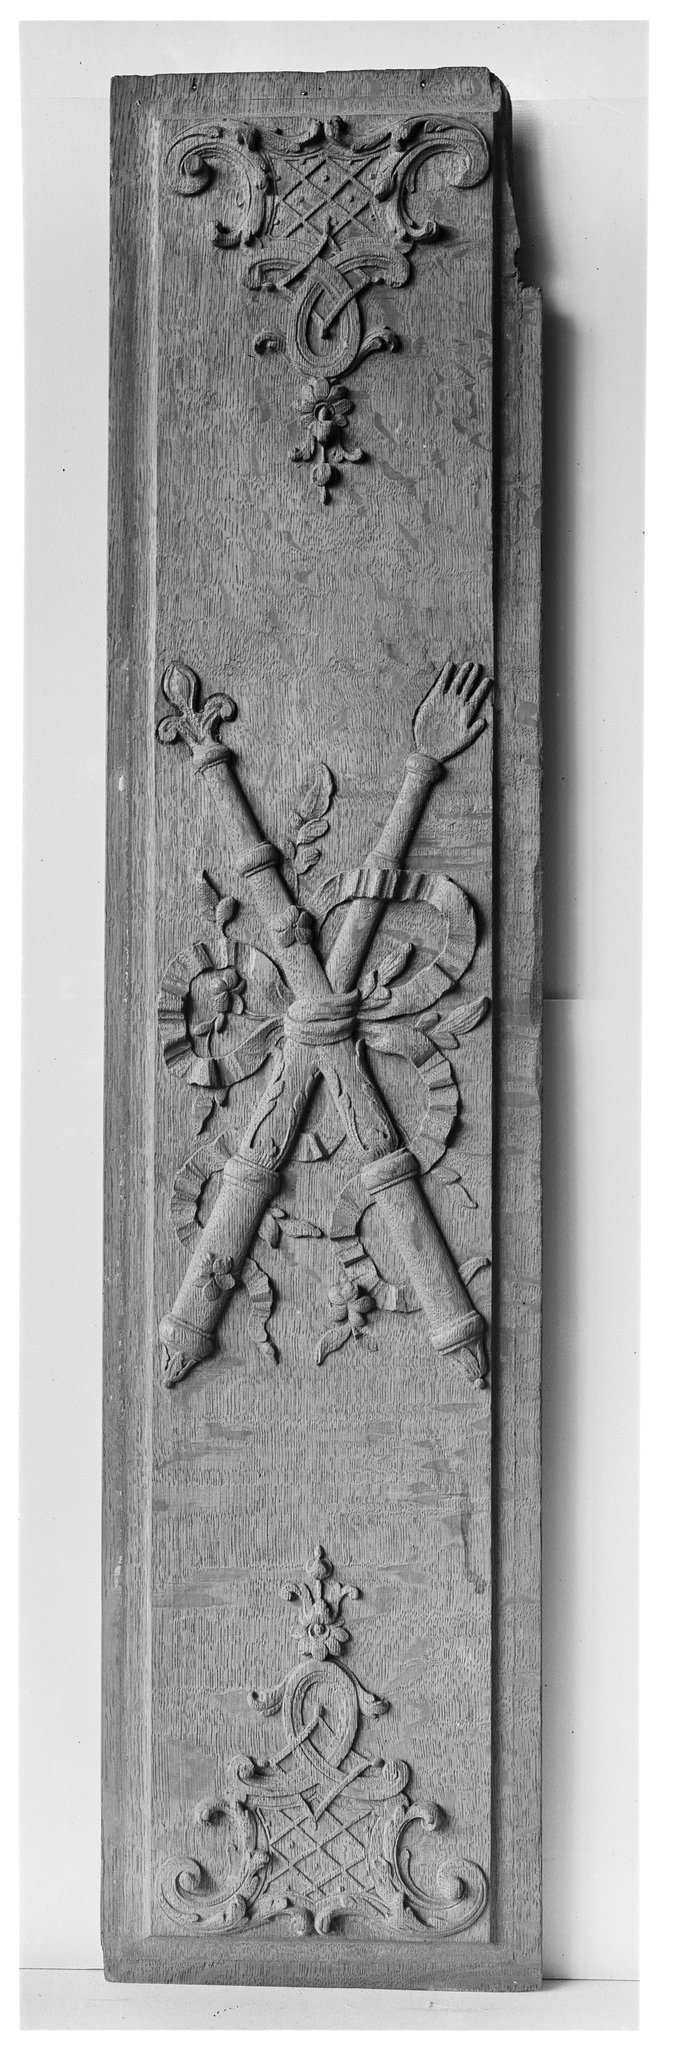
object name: panel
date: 1667-1733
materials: wood